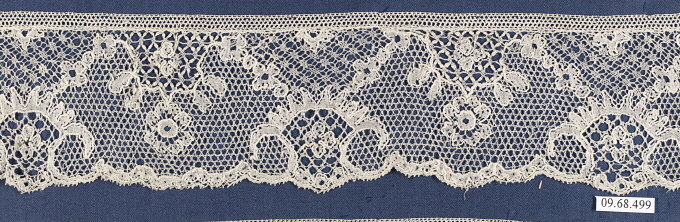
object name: fragment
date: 1801-1900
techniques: lace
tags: flowers,leaves